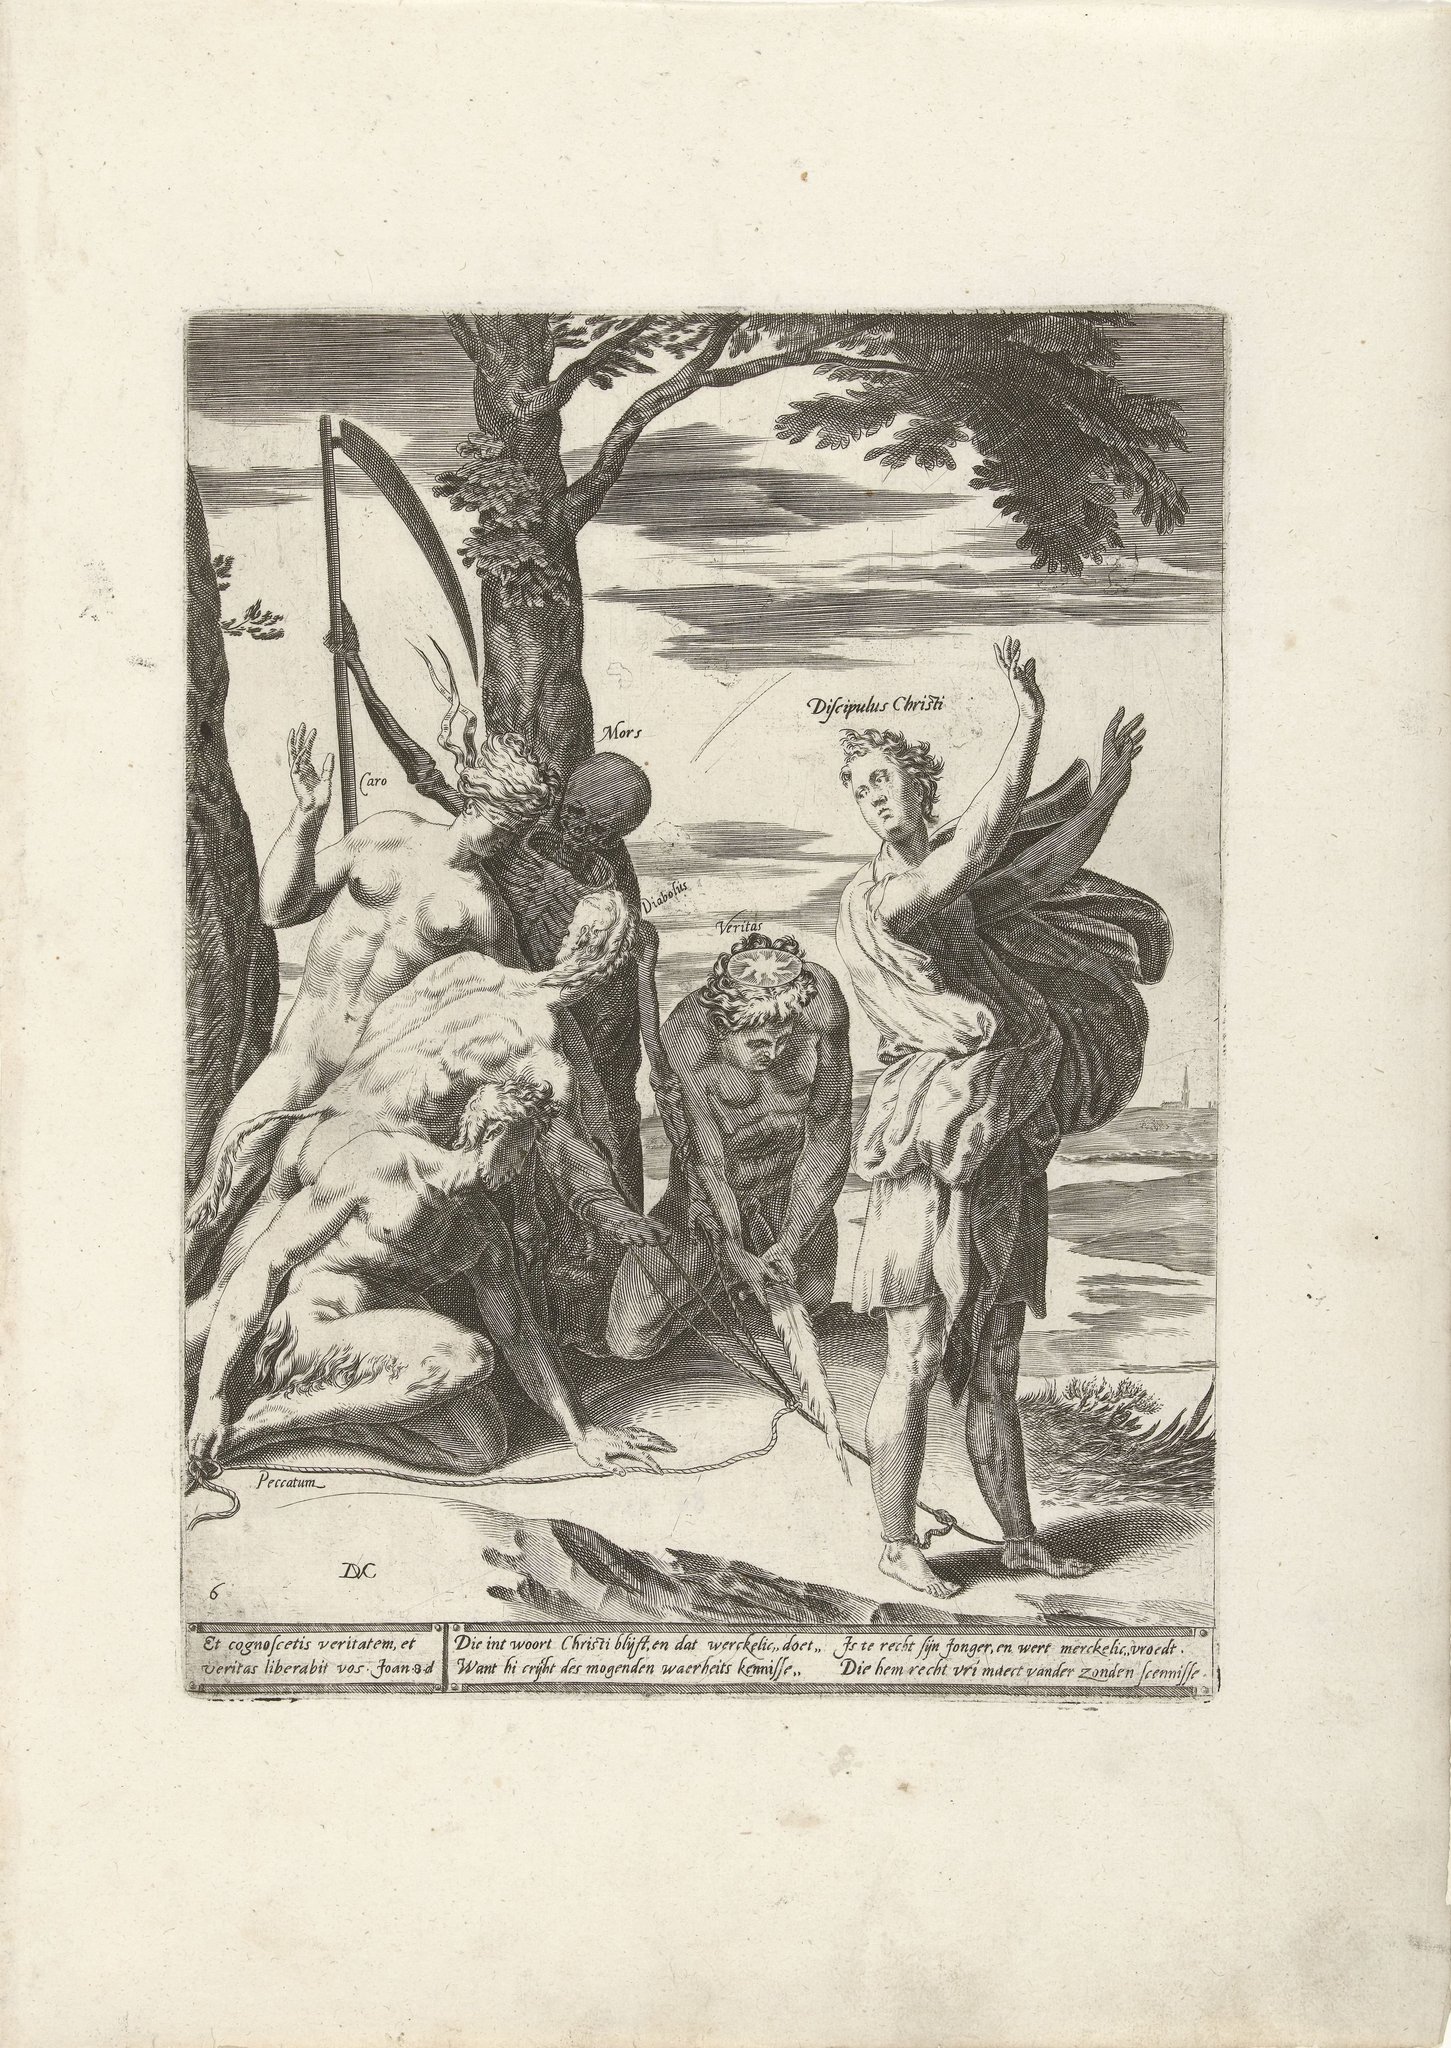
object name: print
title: Triomf van de waarheid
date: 1566-1578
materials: paper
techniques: engraving, etching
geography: germany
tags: death as skeleton, truth; 'verità' (ripa), vice, evil, sin; 'peccato' (ripa), human-shaped devil, amorousness, desire, devotion ~ christ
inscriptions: collector's mark: Lugt 2760, collector's mark: Lugt 2228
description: De mens is door Waarheid een oprechte leerling van Christus (Discipulus Christi) geworden. Waarheid snijdt het koord door tussen de mens en de Dood (Mors, een skelet), de Duivel (Diabolus, half demon en half mens), de Zonde (Peccatum, een sater) en het Vlees (Caro, een naakte vrouw met een blinddoek). De waarheid bevrijdt hem zo van zijn zonden en wereldse zorgen. De prent heeft een Latijns en een Nederlands onderschrift en maakt deel uit van een serie over de triomf van de waarheid.